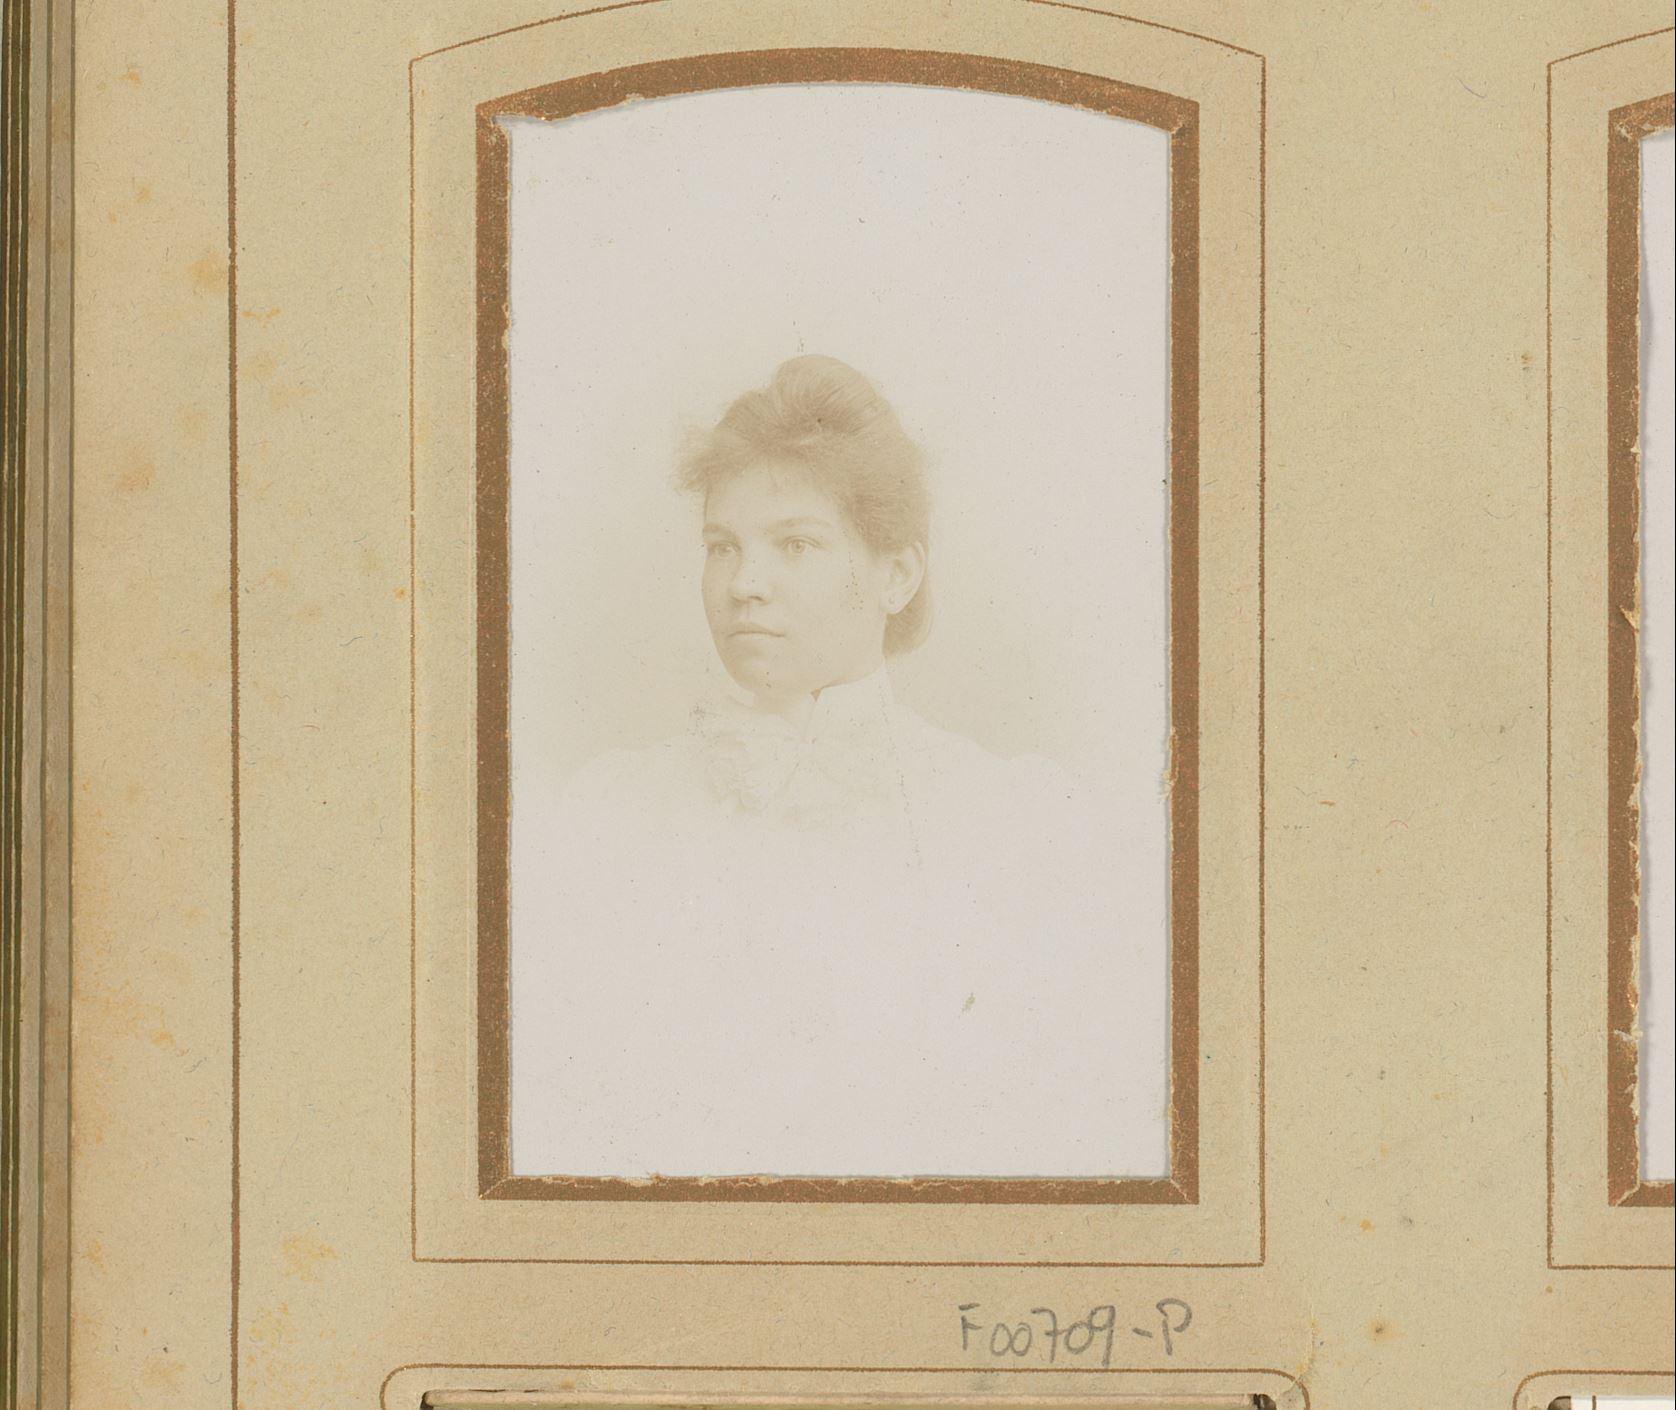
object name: album leaf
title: Portret van een jonge vrouw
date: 1892-1906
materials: cardboard, photographic support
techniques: collodion silver print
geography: rotterdam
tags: adolescent, young woman, maiden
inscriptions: inscription: ‘Jac. & J. Schotel Zn./ Rotterdam/ Erasmusstraat 3/ Schiedamsche Singel 56’